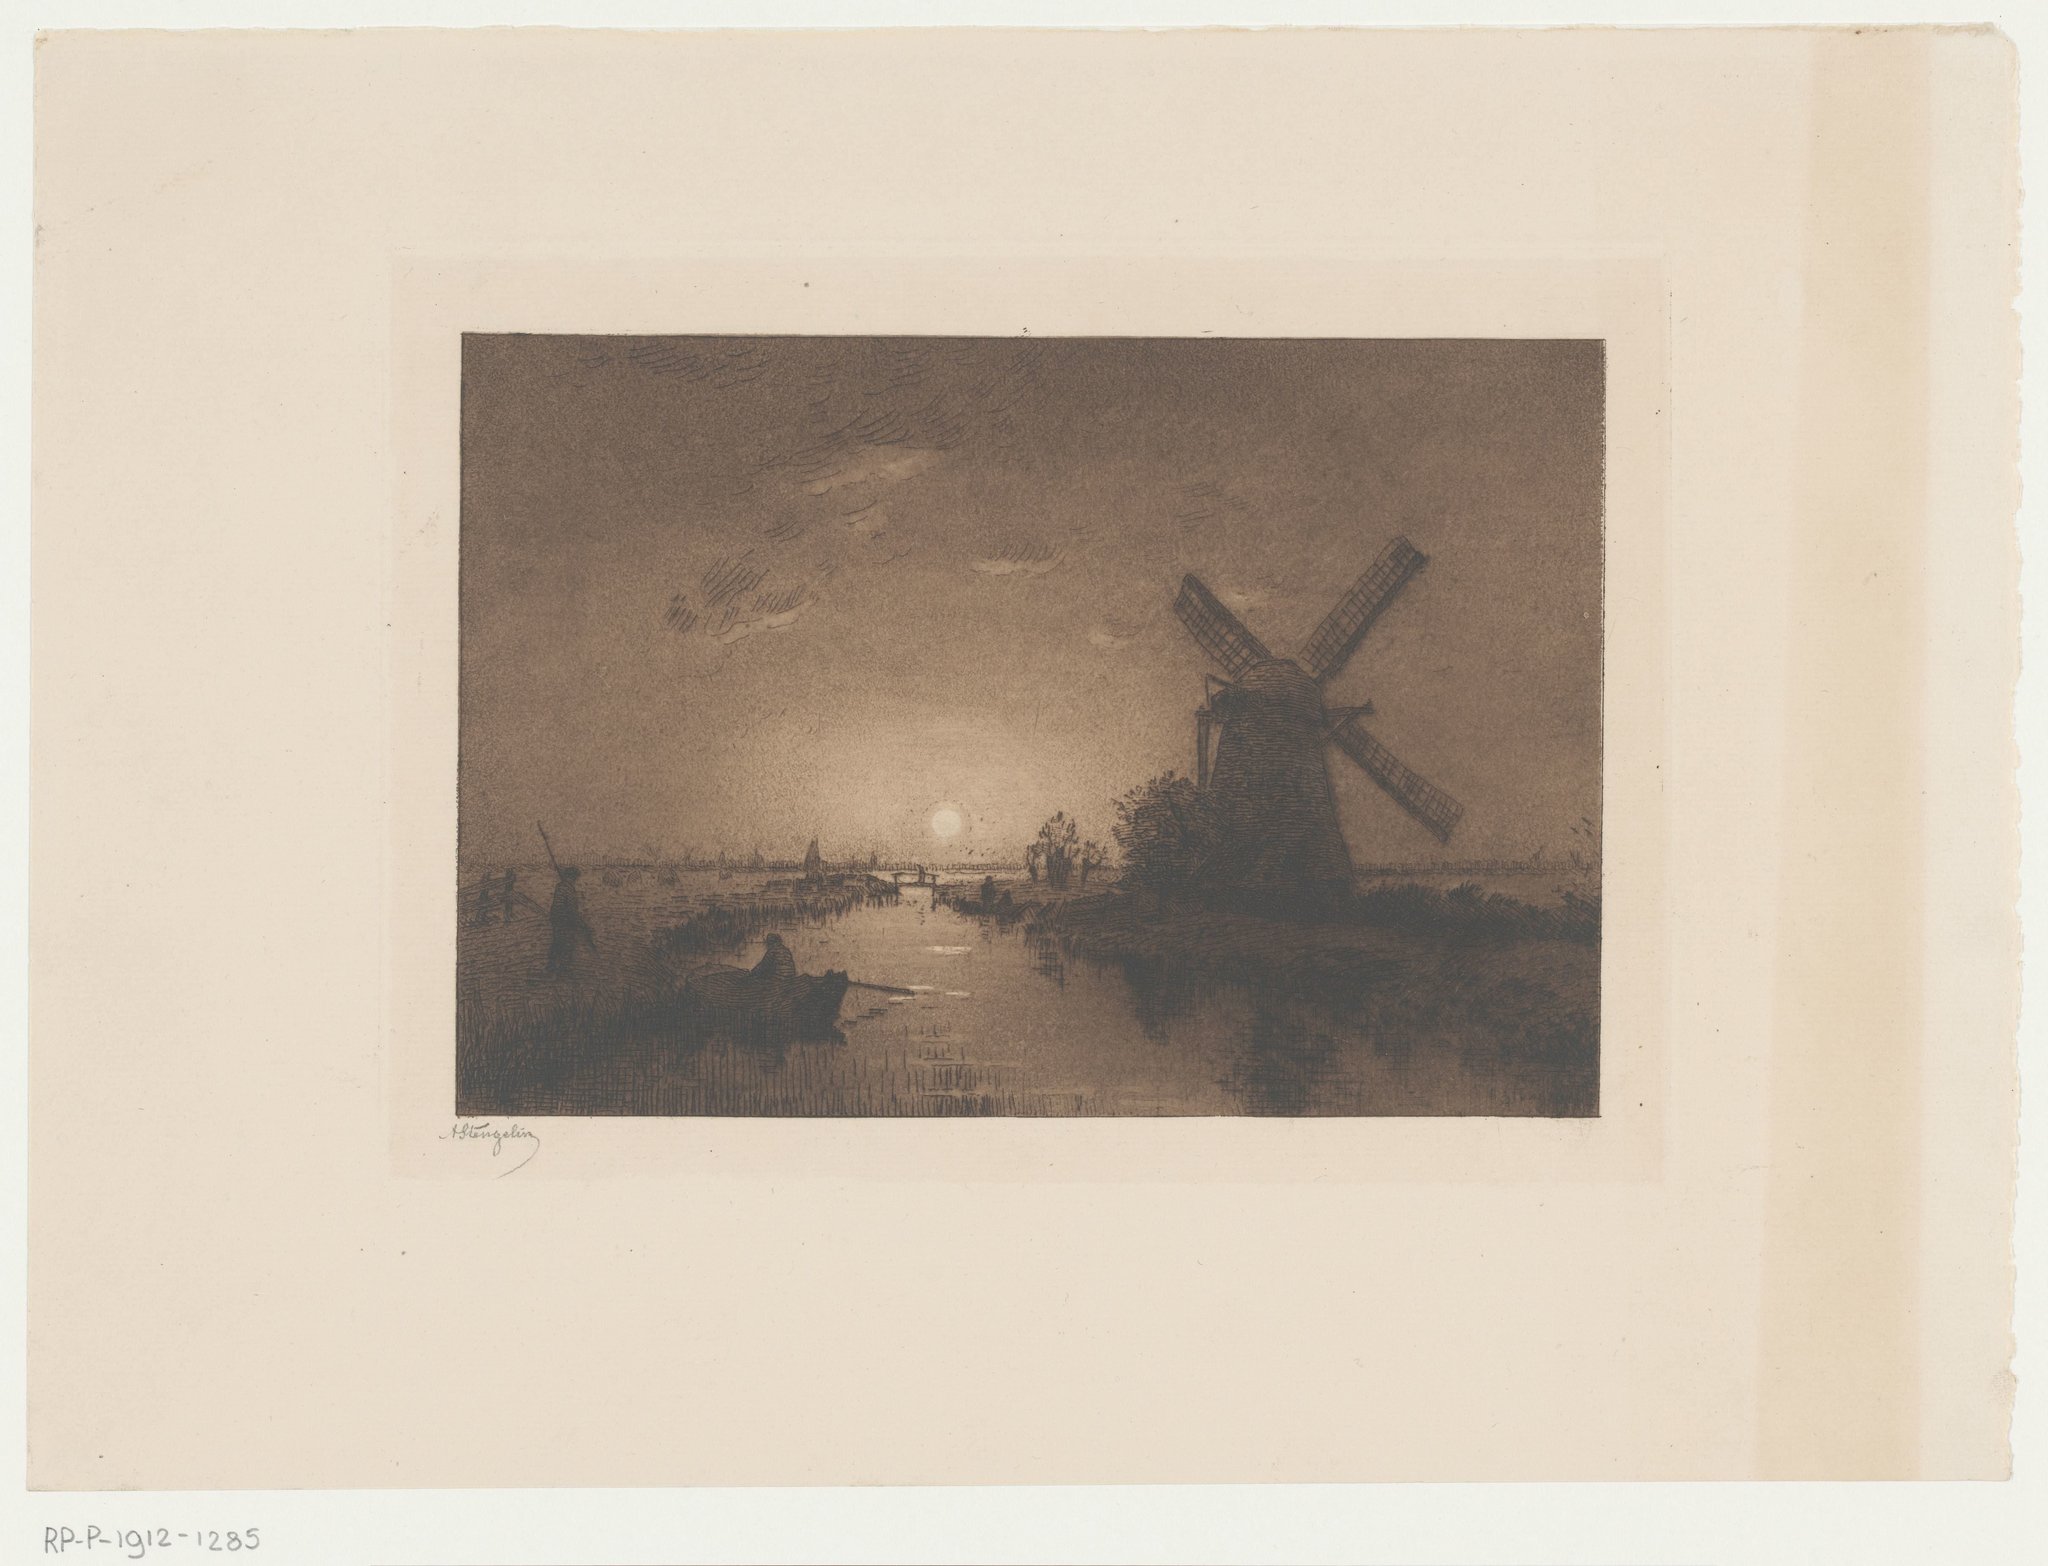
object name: print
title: Landschap met molen bij maanlicht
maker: alphonse stengelin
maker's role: painter, print maker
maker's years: 1852-1938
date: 1862-1912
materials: paper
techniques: aquatint, etching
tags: moonlight, windmill in landscape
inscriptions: collector's mark: Lugt 2228